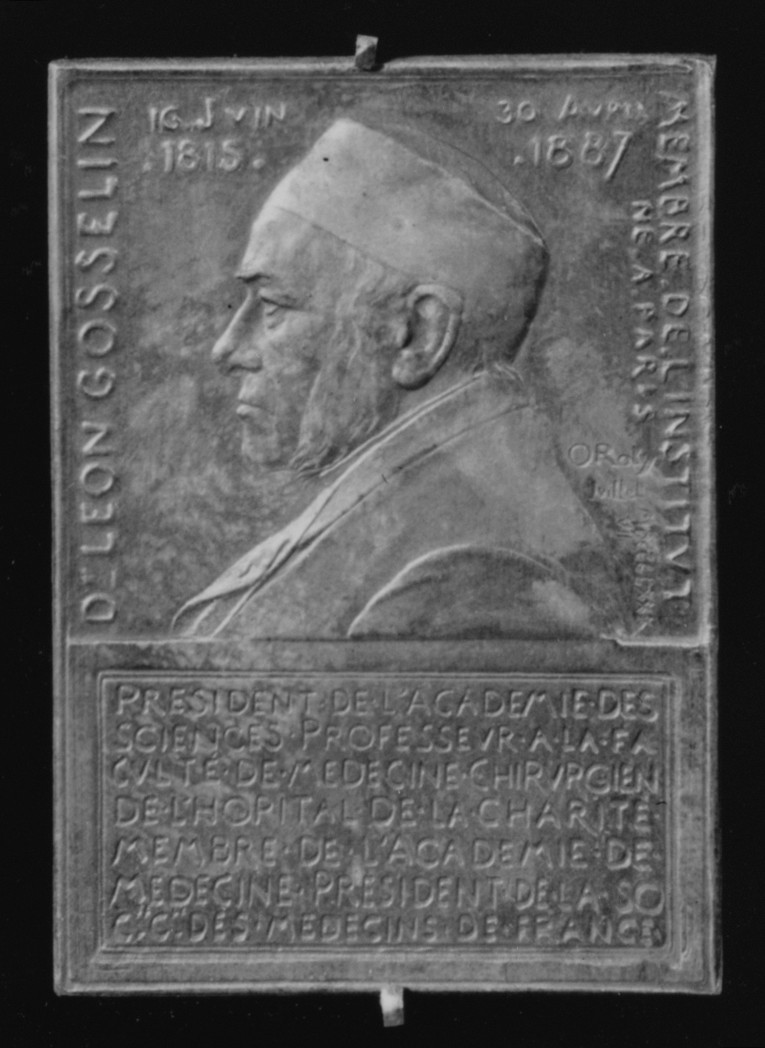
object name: plaque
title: In Memory of Dr. Leon-Athanase Gosselin, French Surgeon (1815–1887)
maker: louis-oscar roty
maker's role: artist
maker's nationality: french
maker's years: 1846-1911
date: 1888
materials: bronze, patina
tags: men,profiles